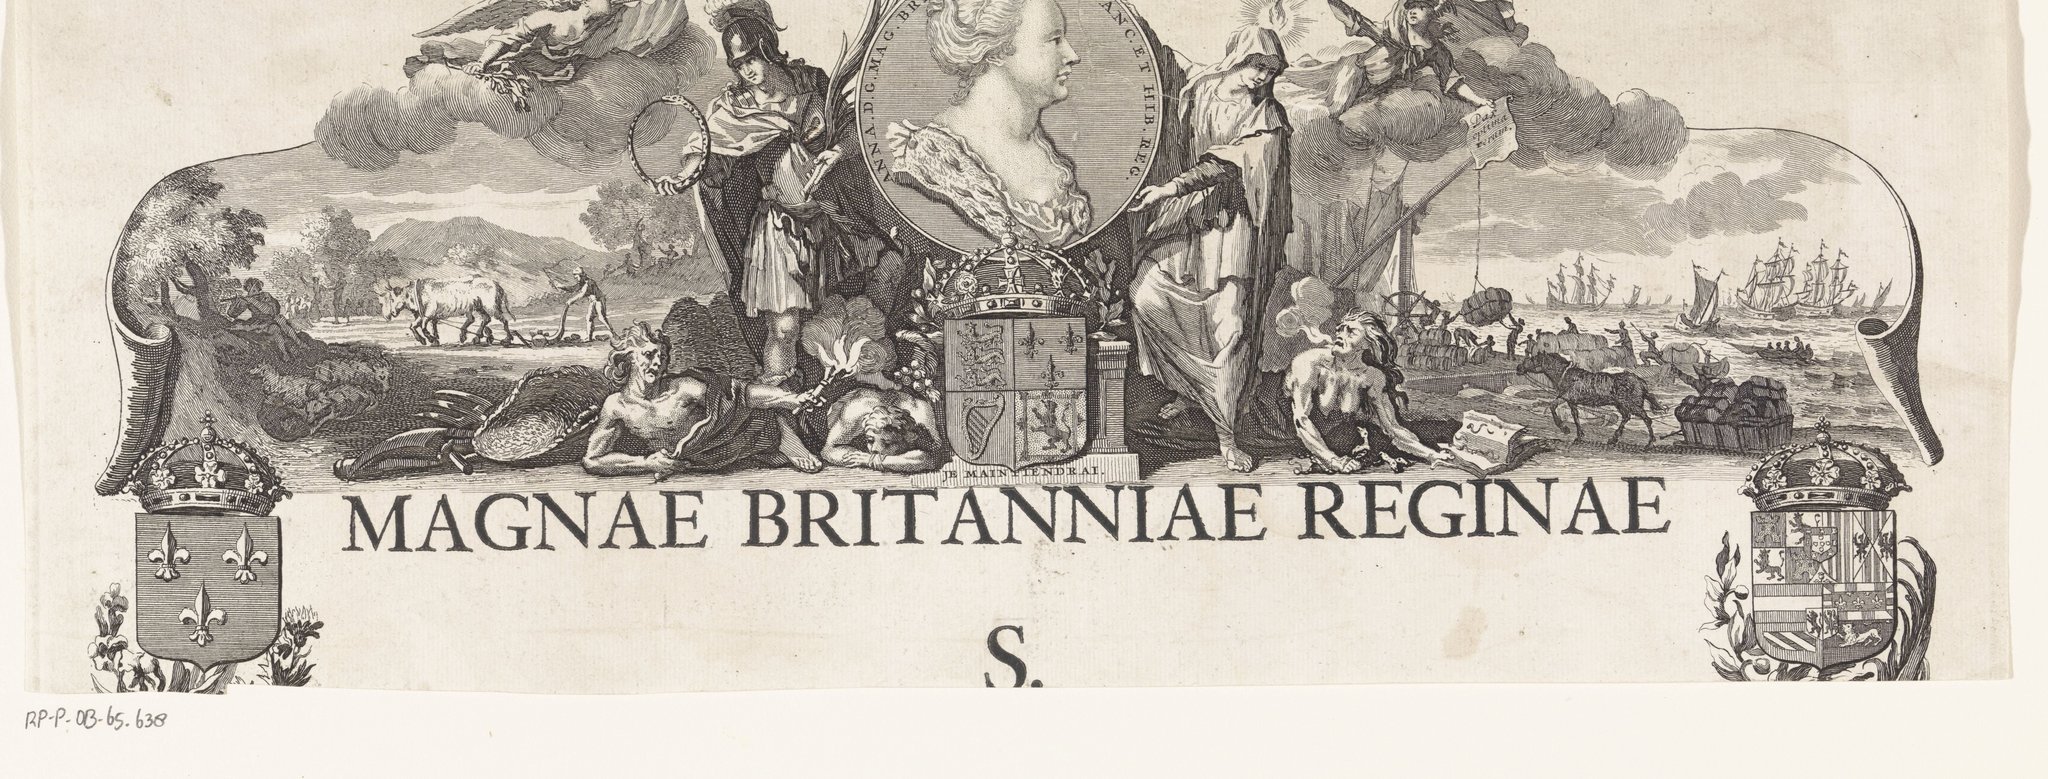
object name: print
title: Bovenste fragment van een allegorie ter ere van koningin Anna in het bereiken van de Vrede van Utrecht, 1713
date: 1713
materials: paper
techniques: etching, letterpress printing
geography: leeuwarden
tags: london, anna stuart (koningin van engeland en schotland), consequences of peace, armorial bearing, heraldry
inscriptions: collector's mark: Lugt 2228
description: Allegorie ter ere van koningin Anna en haar rol in het bereiken van de Vrede van Utrecht, 1713. Bovenaan een portret van koningin Anna, te midden van scènes van het herstel van de landbouw en de handel dankzij de vrede. Aan de zijkanten de wapenschilden van de partijen in de oorlog.